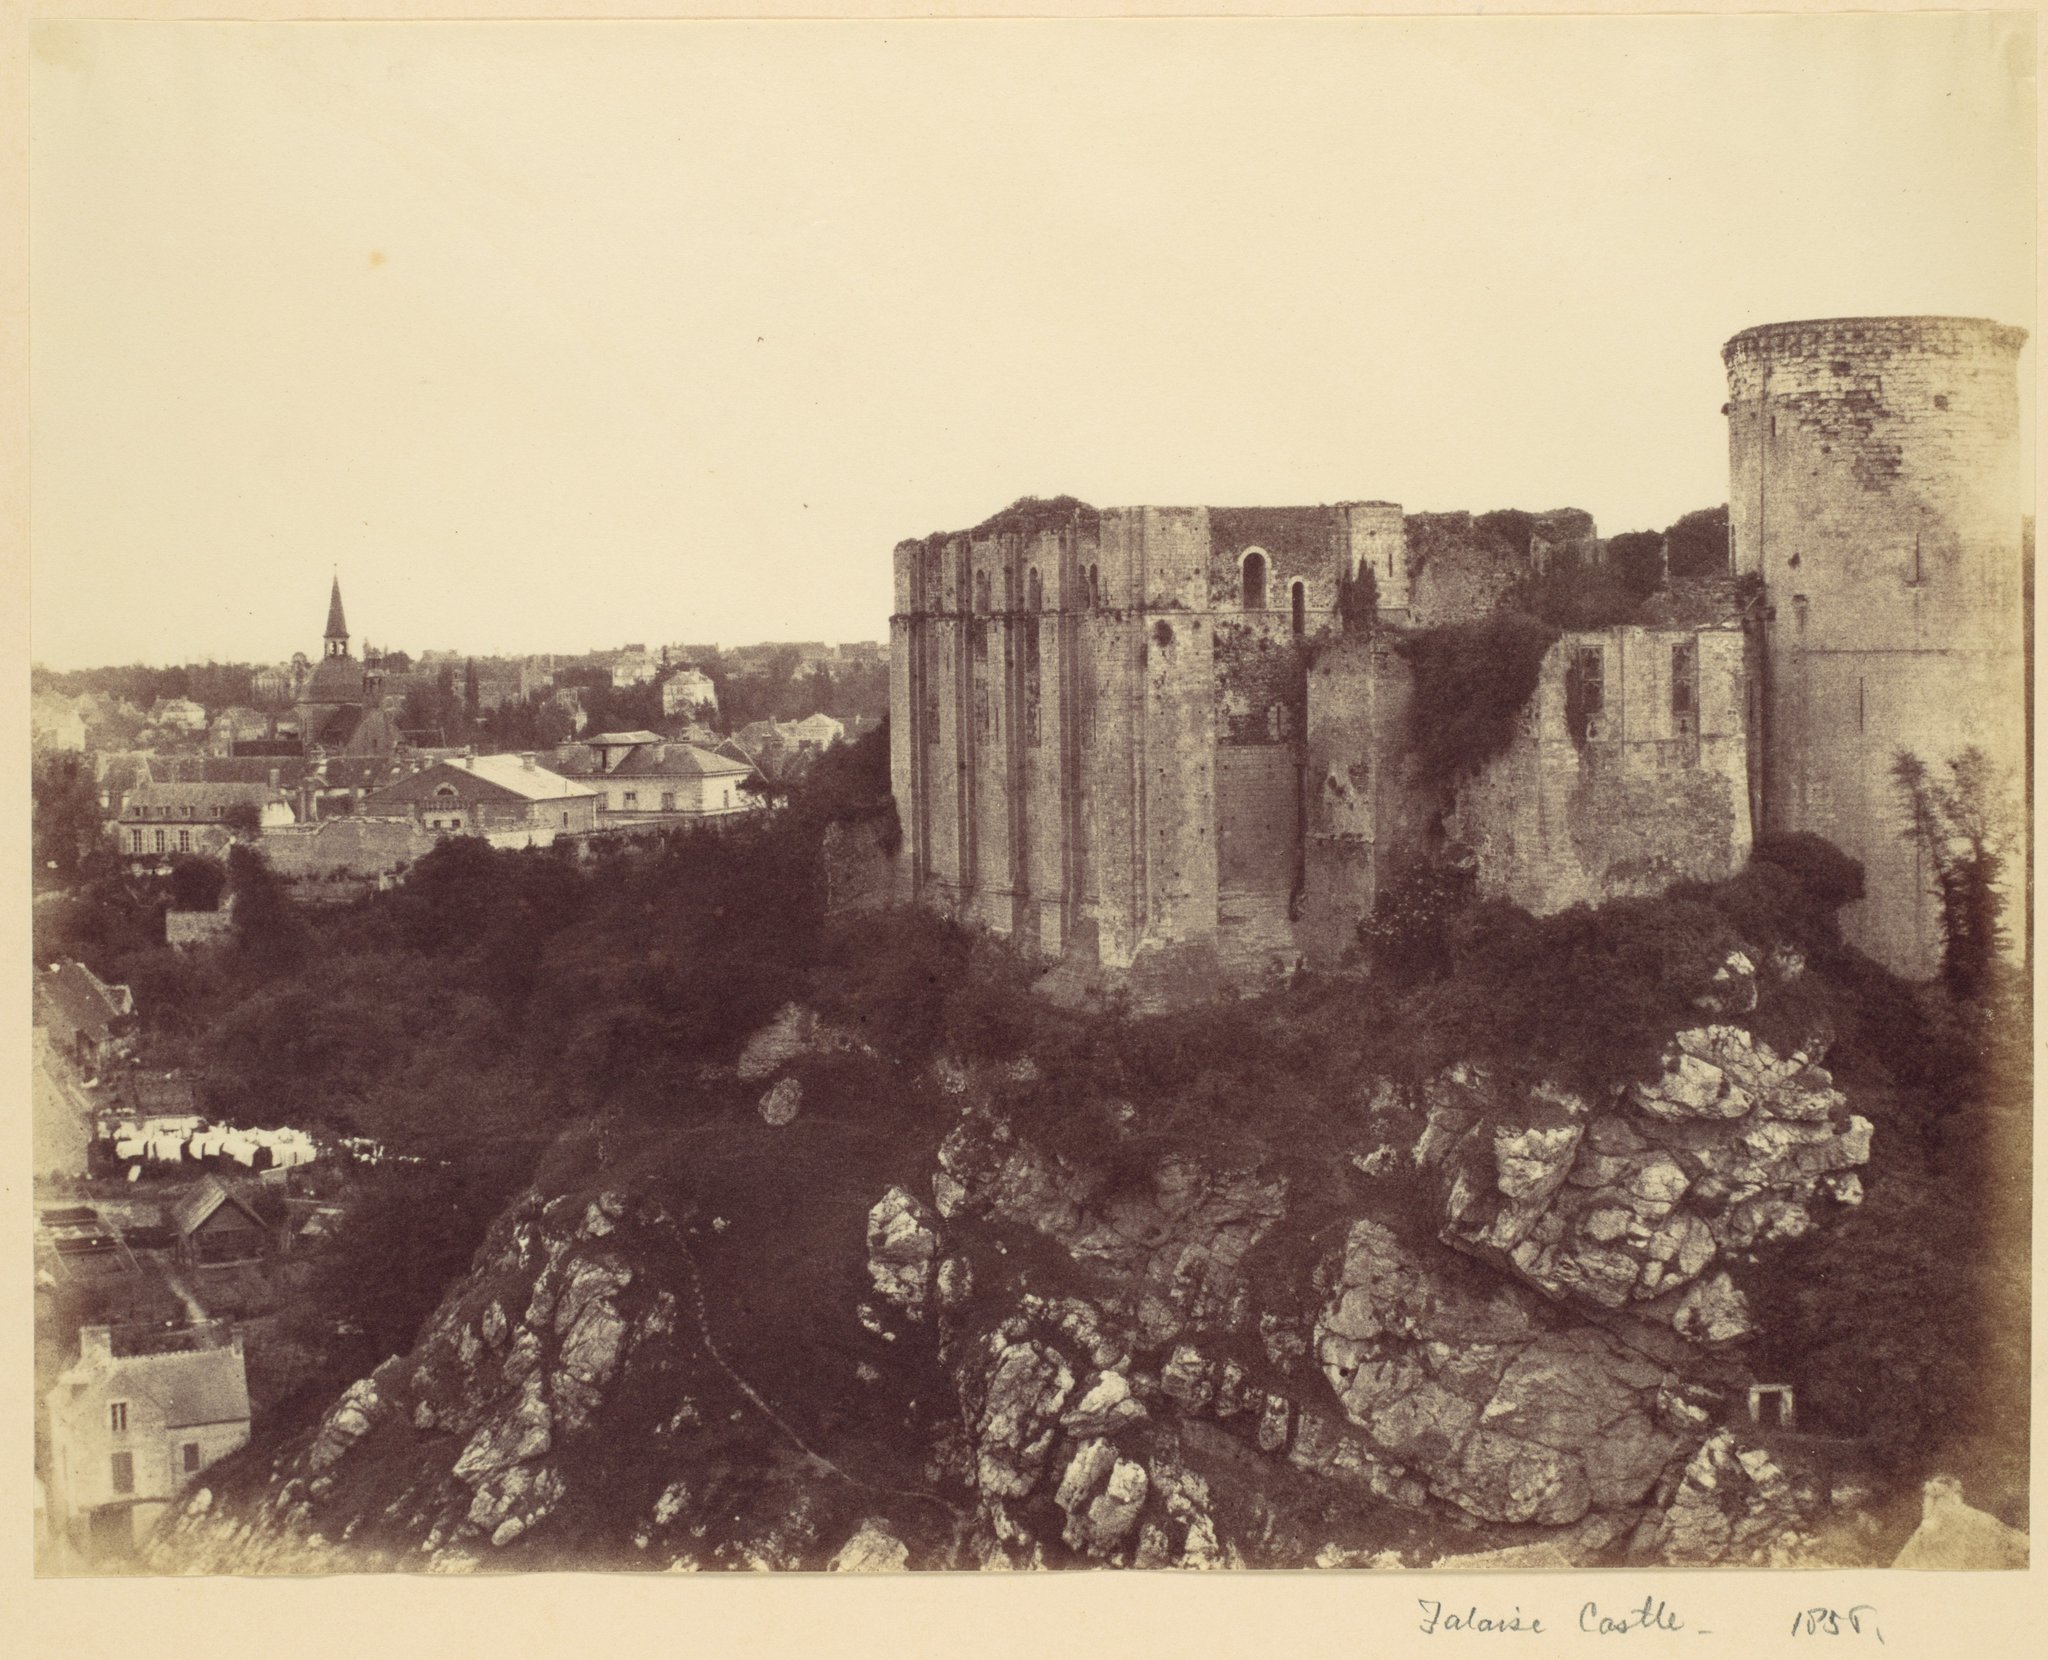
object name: photograph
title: Falaise Castle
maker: alfred capel cure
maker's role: artist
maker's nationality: british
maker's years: 1826-1896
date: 1856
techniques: albumen silver print, paper negative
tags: architecture,castles